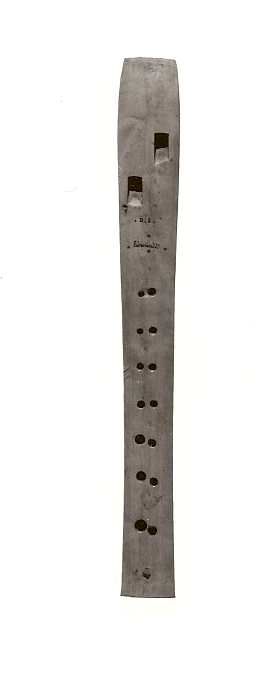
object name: double recorder in f left hand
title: Double Recorder in F (left hand)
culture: swiss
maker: ulrich ammann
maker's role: maker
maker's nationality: swiss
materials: wood, ivory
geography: switzerland